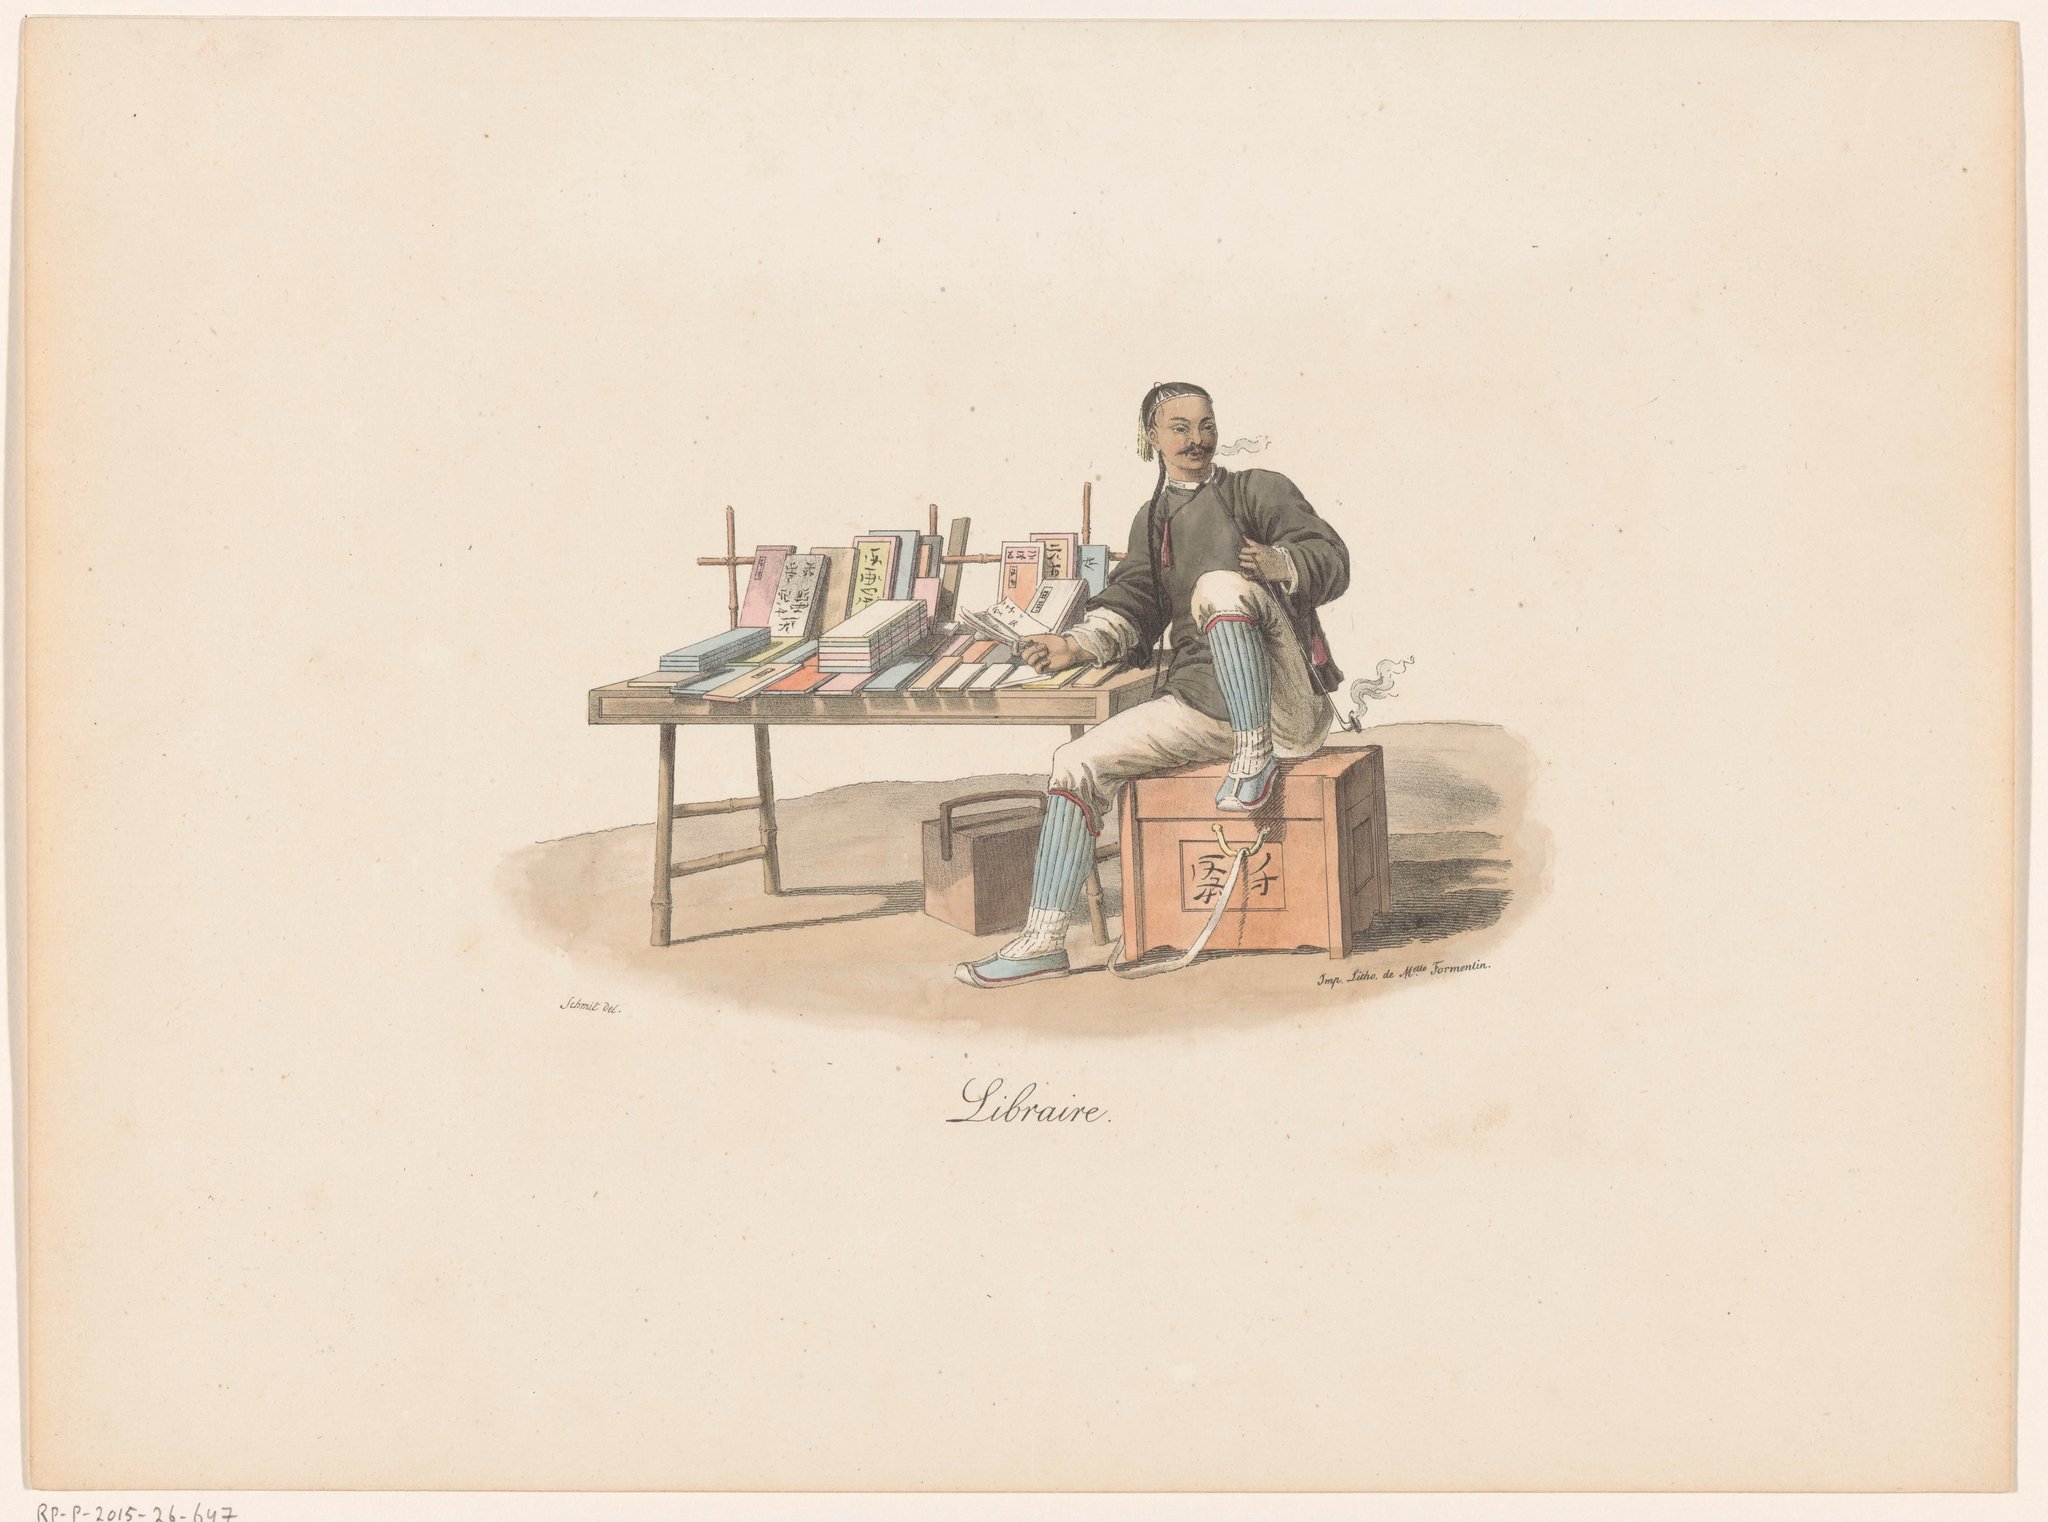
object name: print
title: Libraire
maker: mademoiselle formentin (joséphine clémence)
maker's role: print maker, printer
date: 1825-1827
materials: paper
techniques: hand coloring, lithograph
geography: paris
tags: chinese, pipe ~ tobacco, book-shop, bookseller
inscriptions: collector's mark: Lugt 4780, collector's mark: Lugt 2228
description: Prent mogelijk afkomstig uit: Malpière, D. Bazin de. La Chine, moeurs, usages, costumes (...). 2 dln. Parijs, 1825-1827.